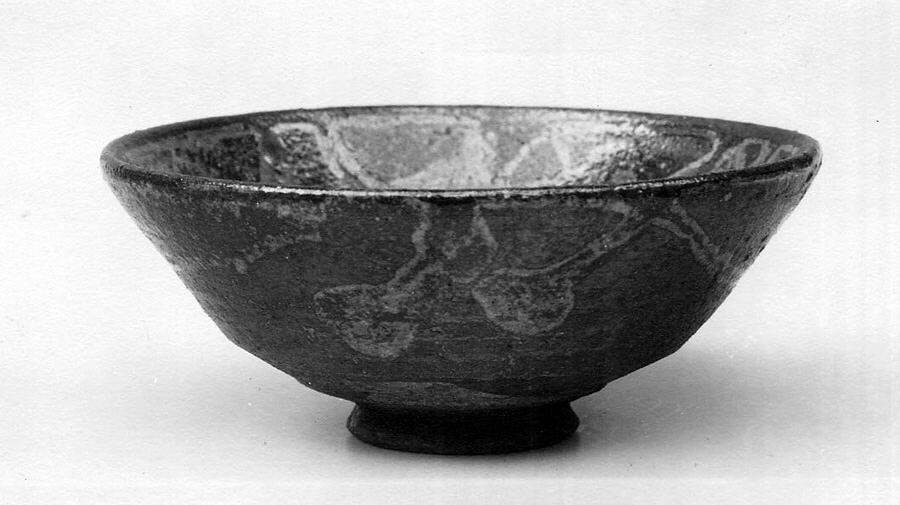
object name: teabowl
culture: japanese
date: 1780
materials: clay, glaze, ribbon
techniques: overglaze